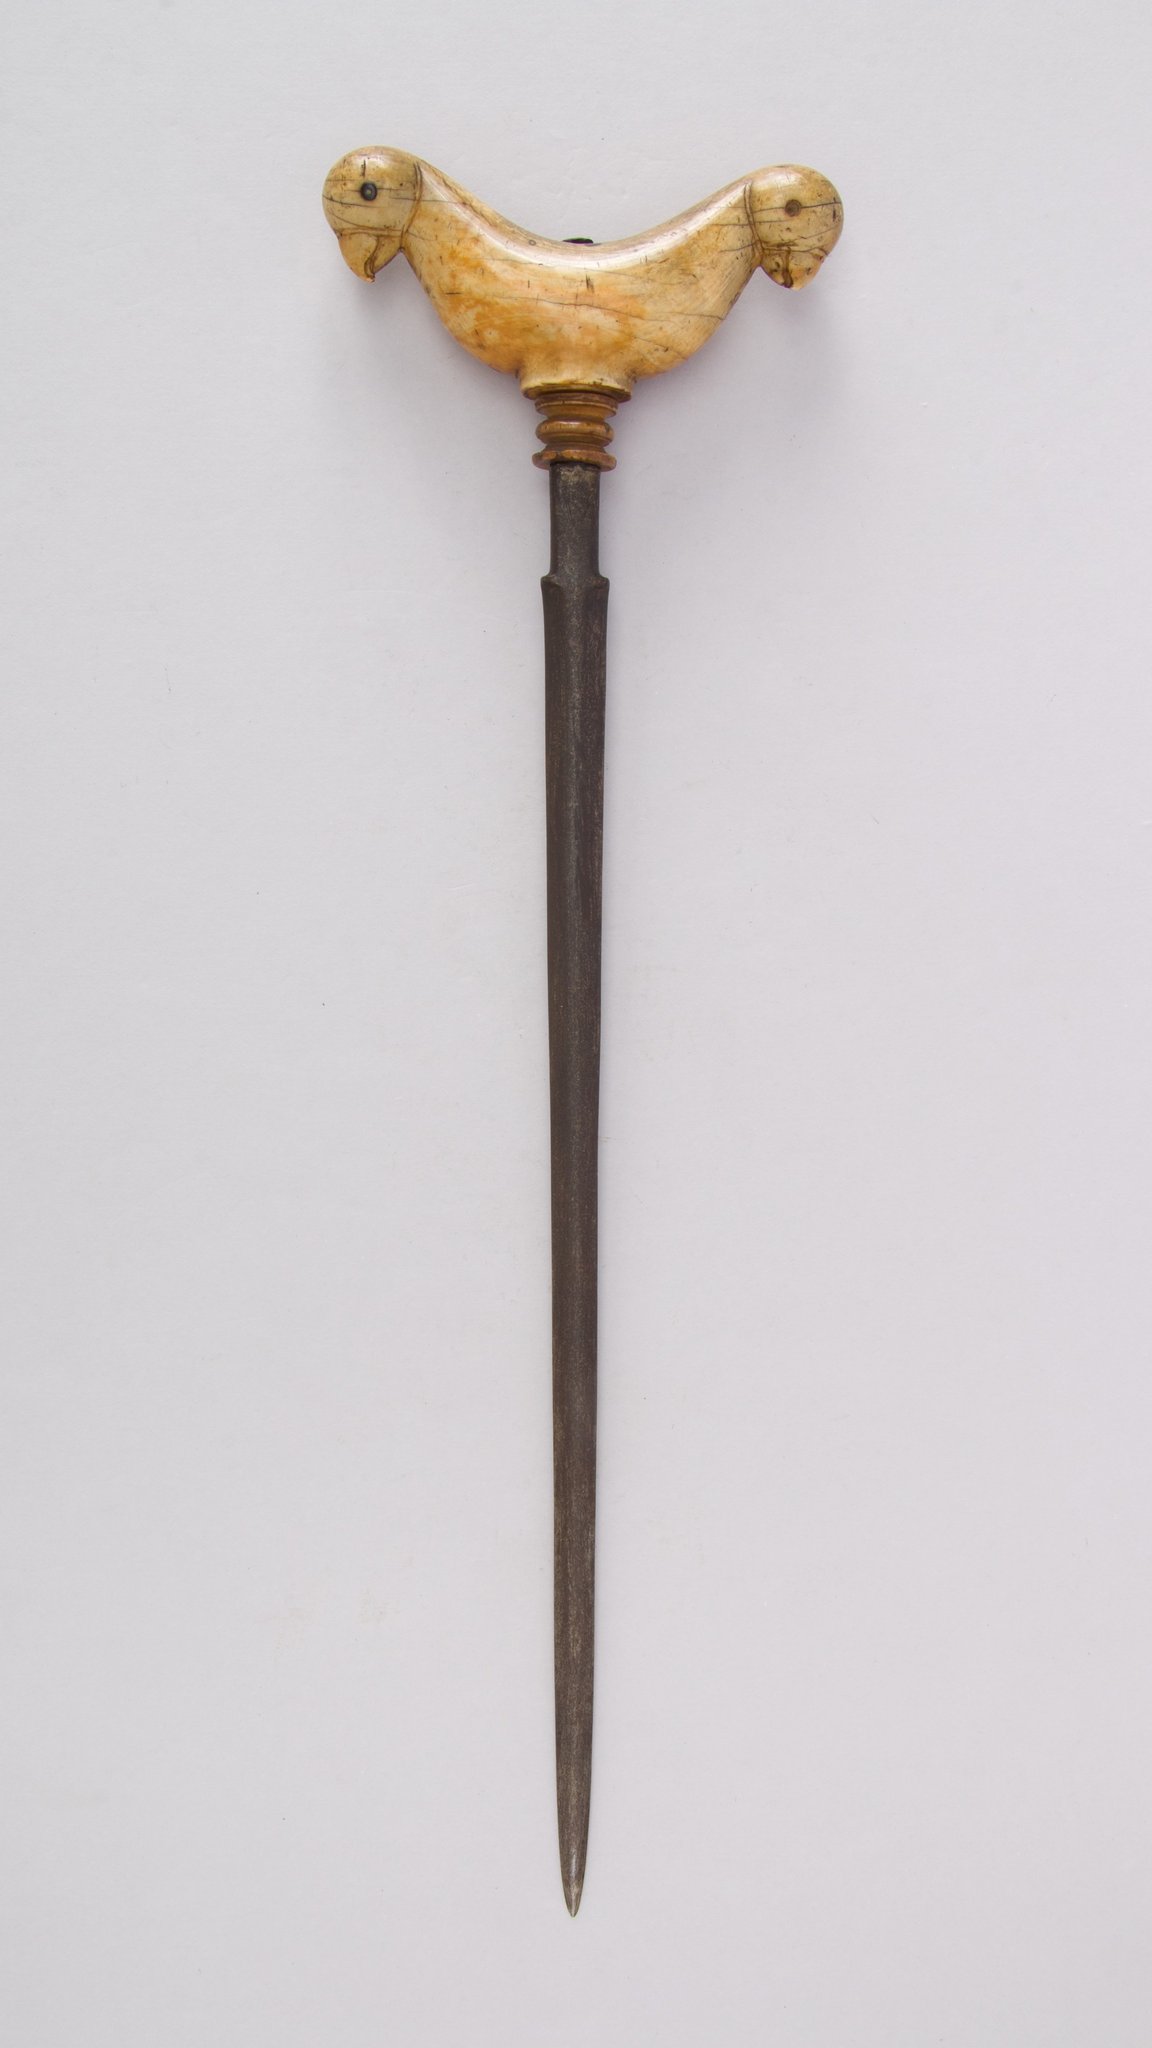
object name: crutch dagger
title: Crutch Dagger (Zafar Takieh, "Cushion of Victory")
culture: european or south indian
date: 1601-1800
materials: ivory, steel